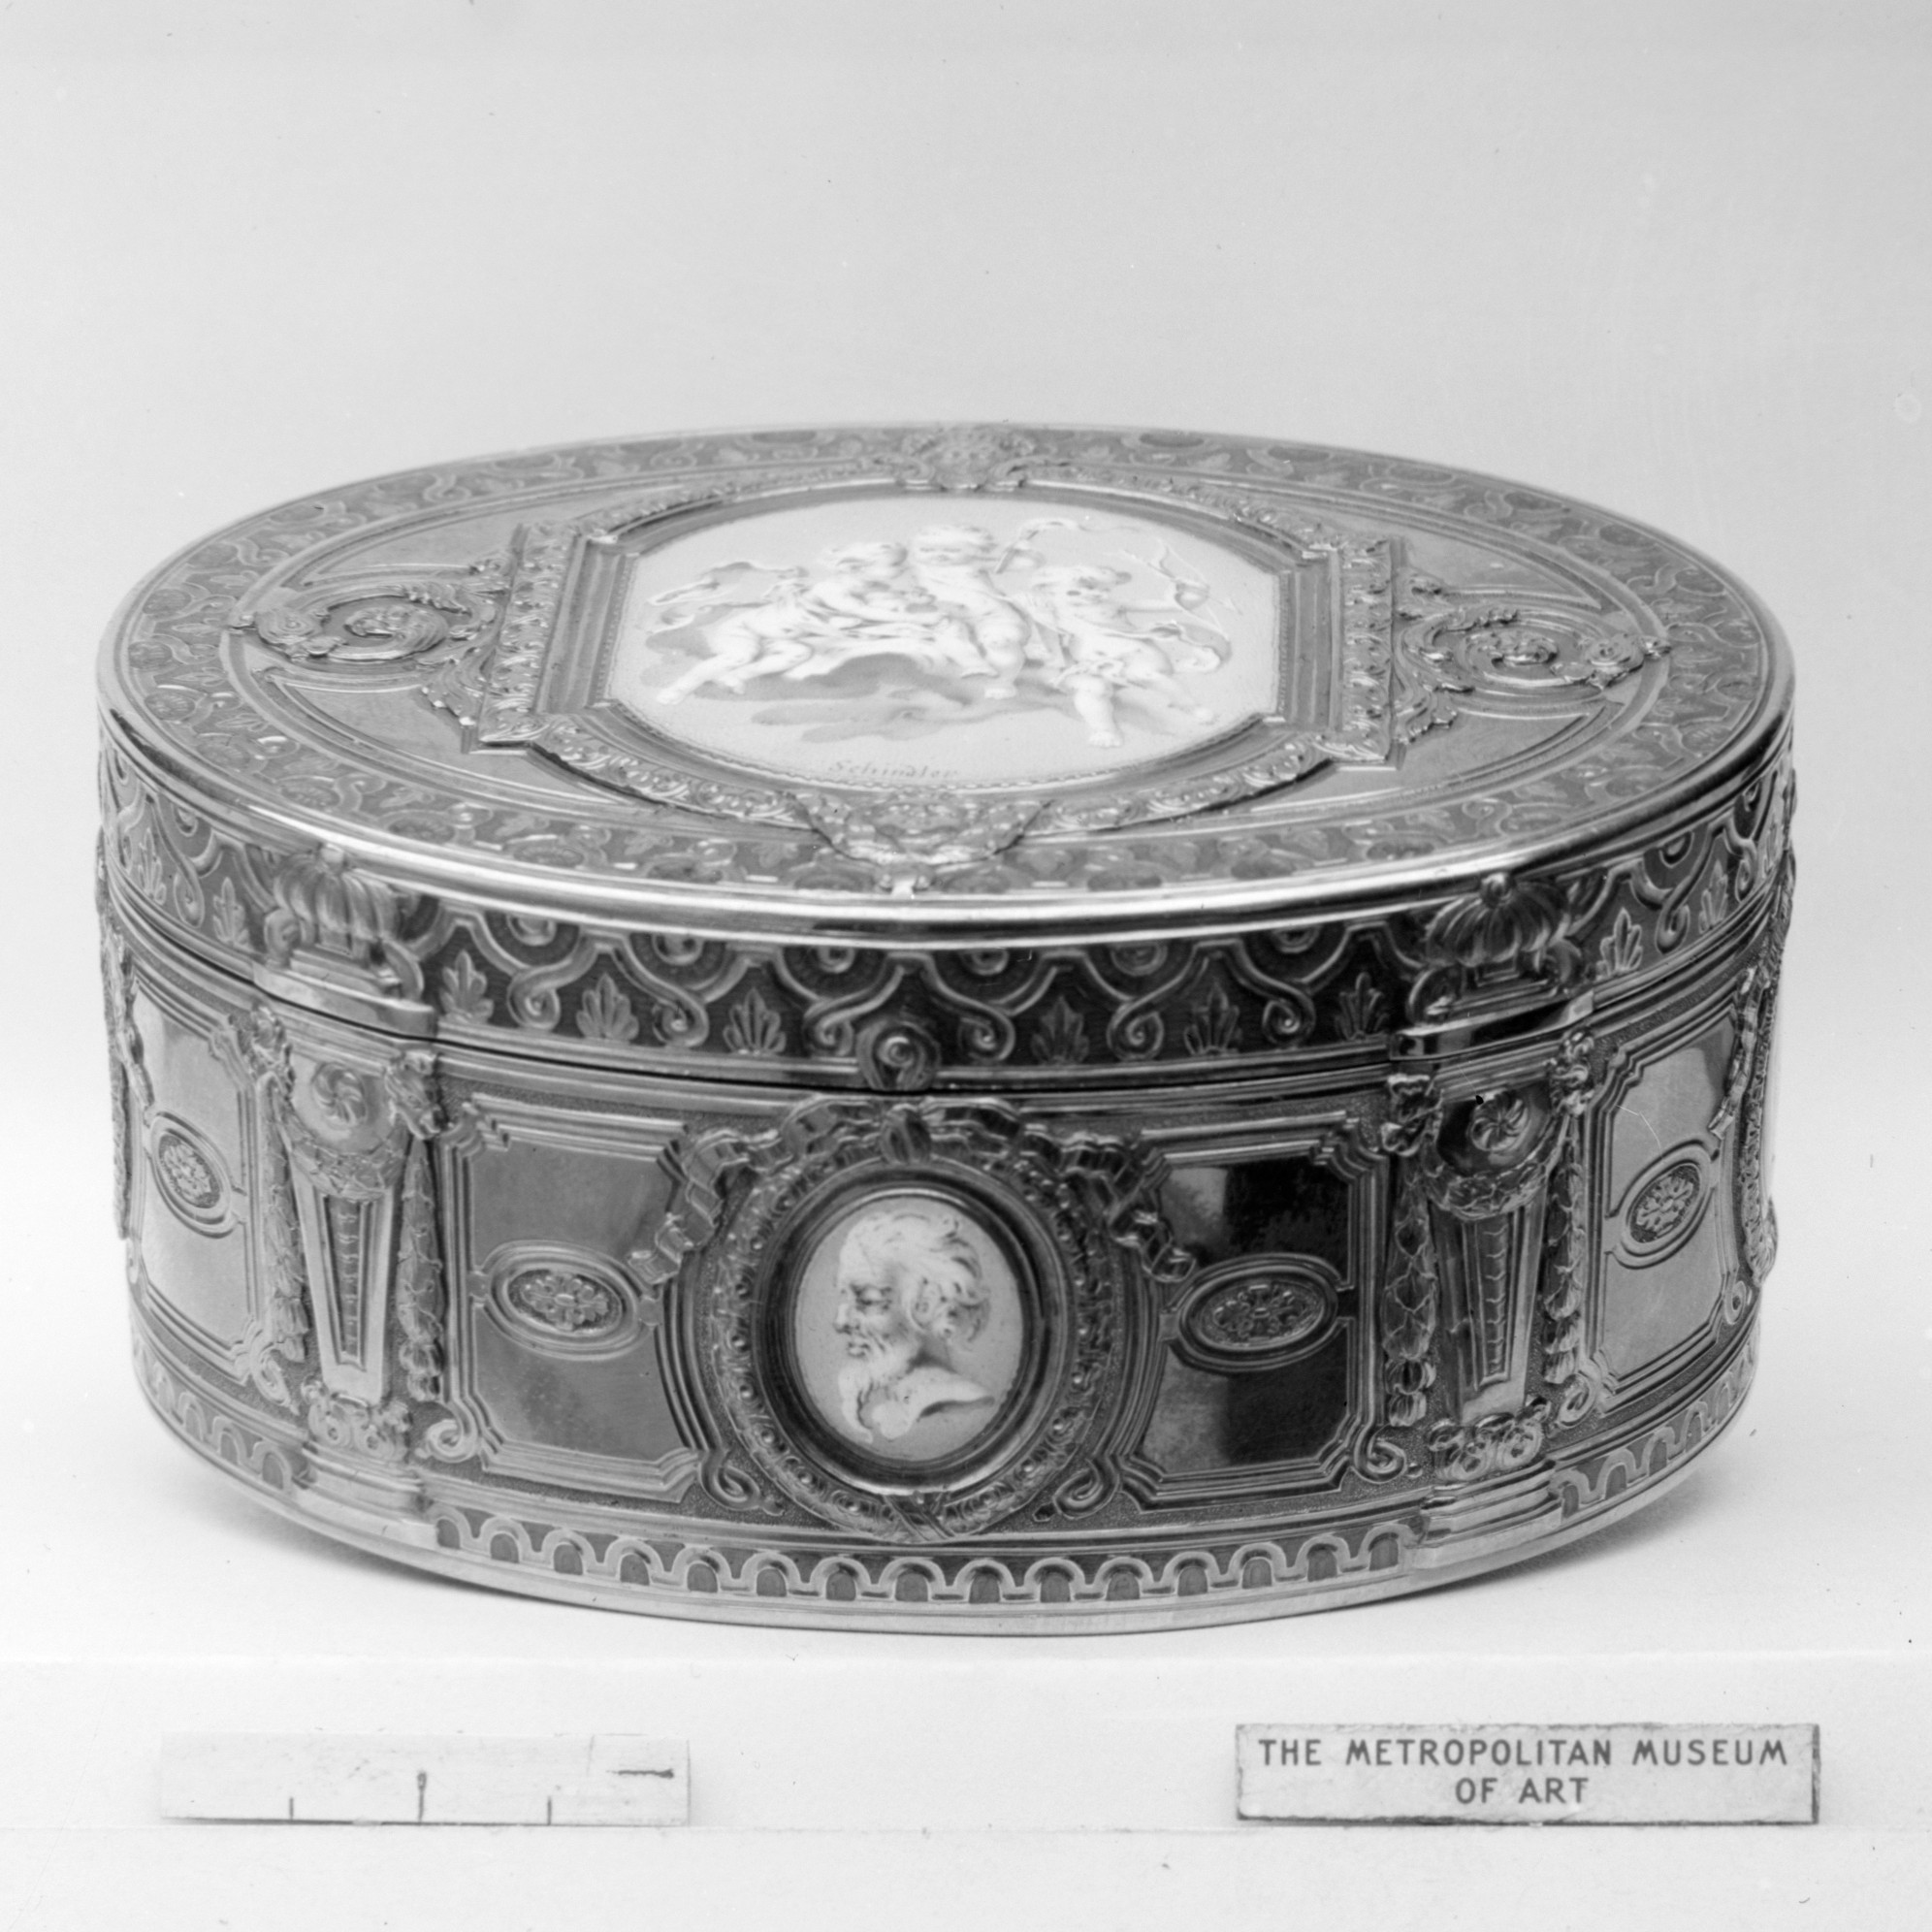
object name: snuffbox, painting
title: Snuffbox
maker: p.m.c.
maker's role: maker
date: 1770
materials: enamel, gold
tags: infants,men,profiles